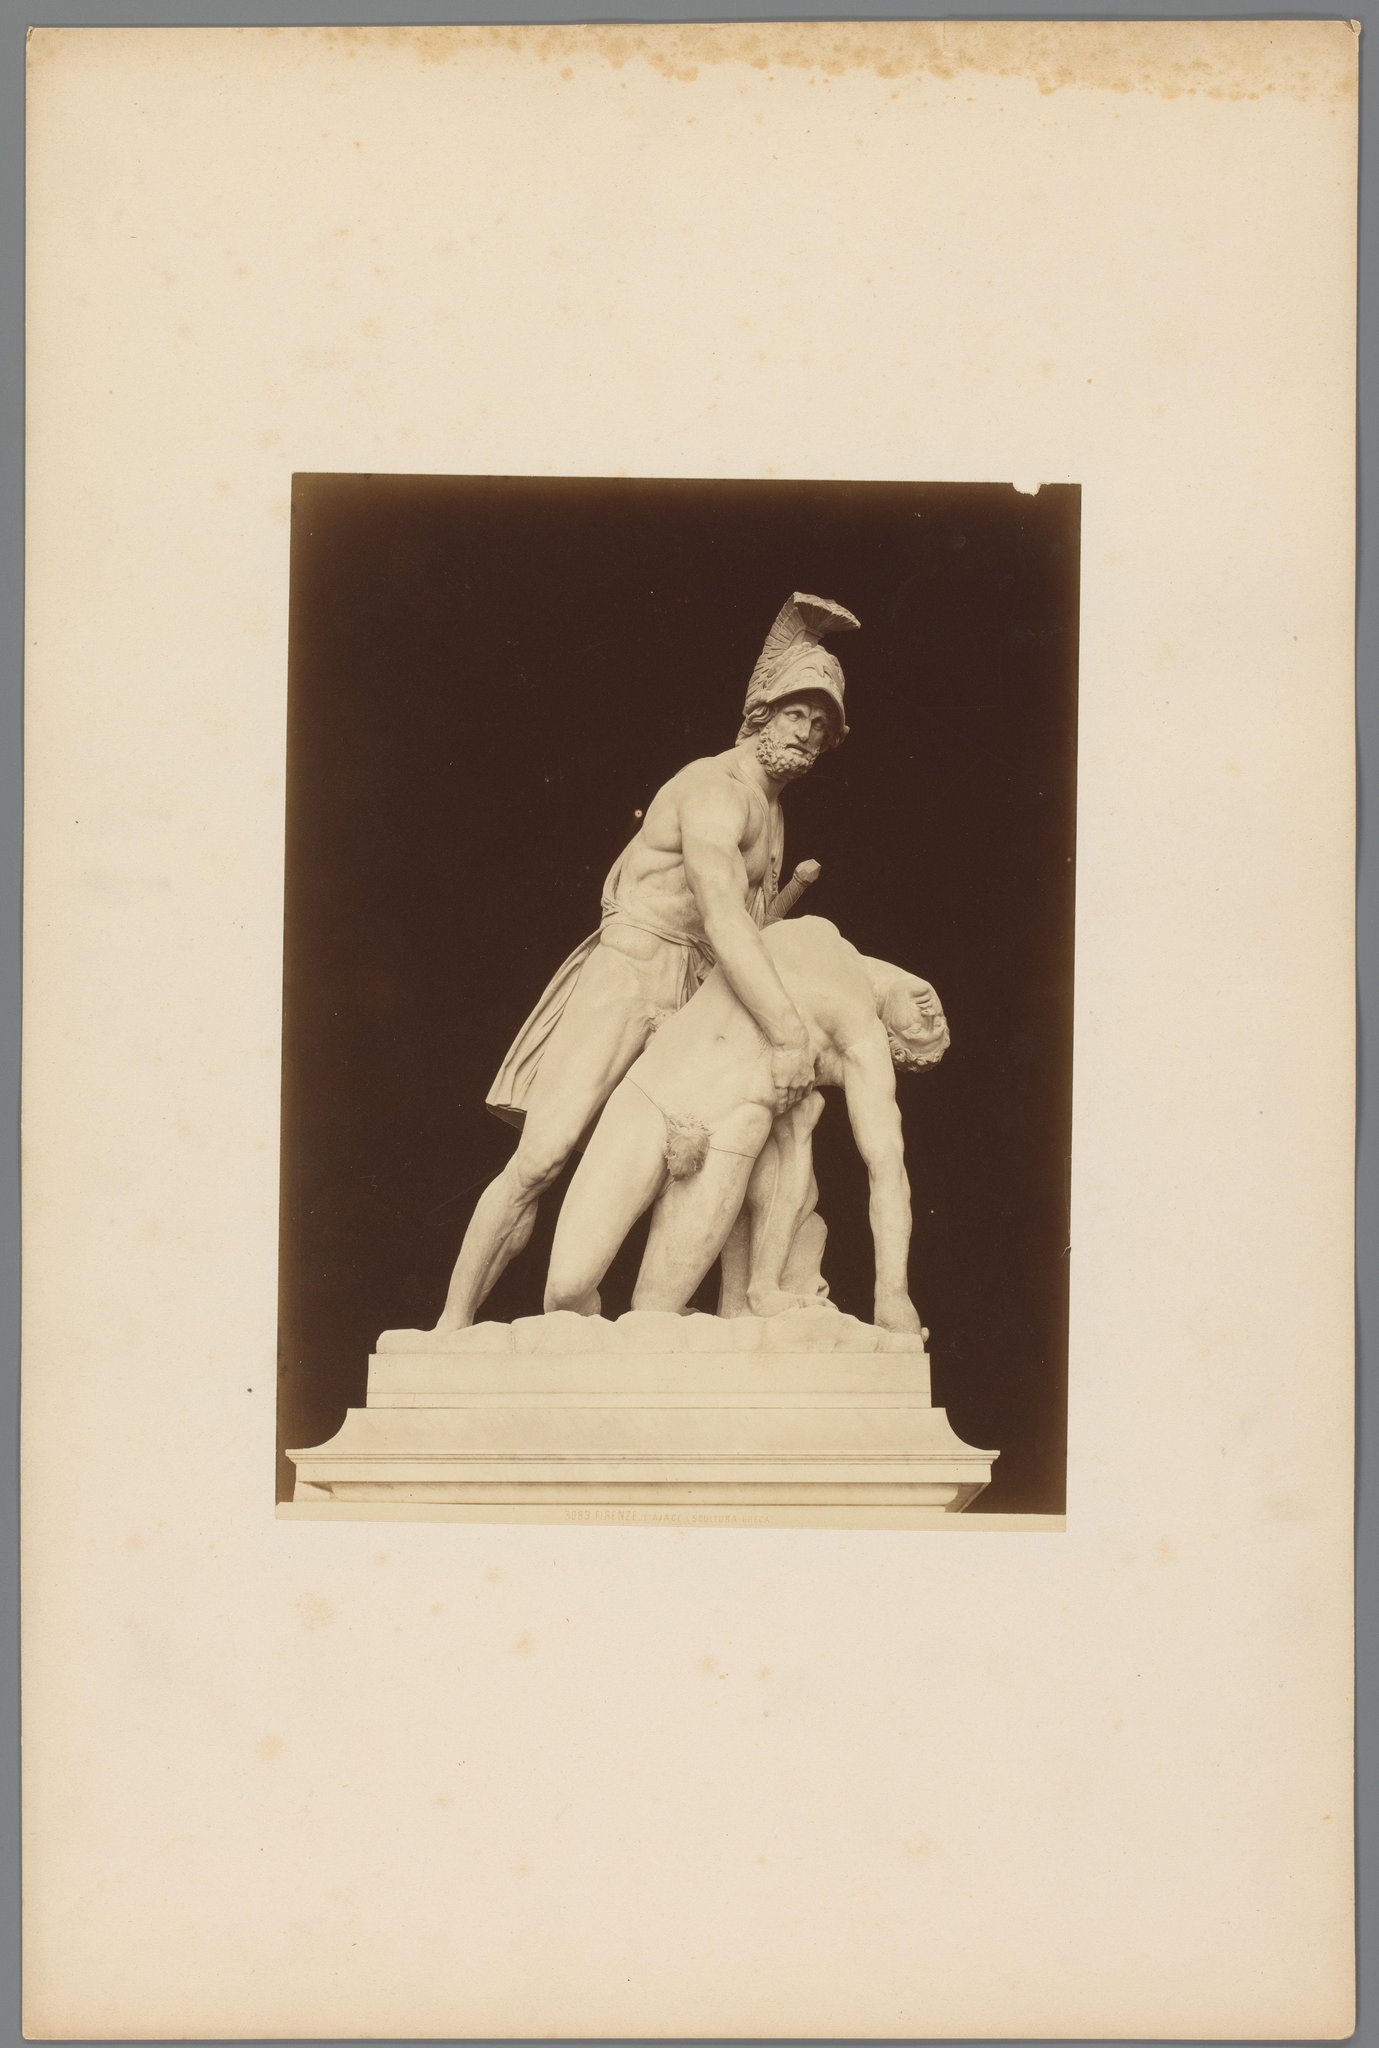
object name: photograph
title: Firenze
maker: Anonymous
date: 1851-1900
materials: cardboard, paper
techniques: albumen print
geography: florence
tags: menelaus carries patroclus' body from the battle-field, piece of sculpture, reproduction of a piece of sculpture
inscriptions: number: ‘3083.’